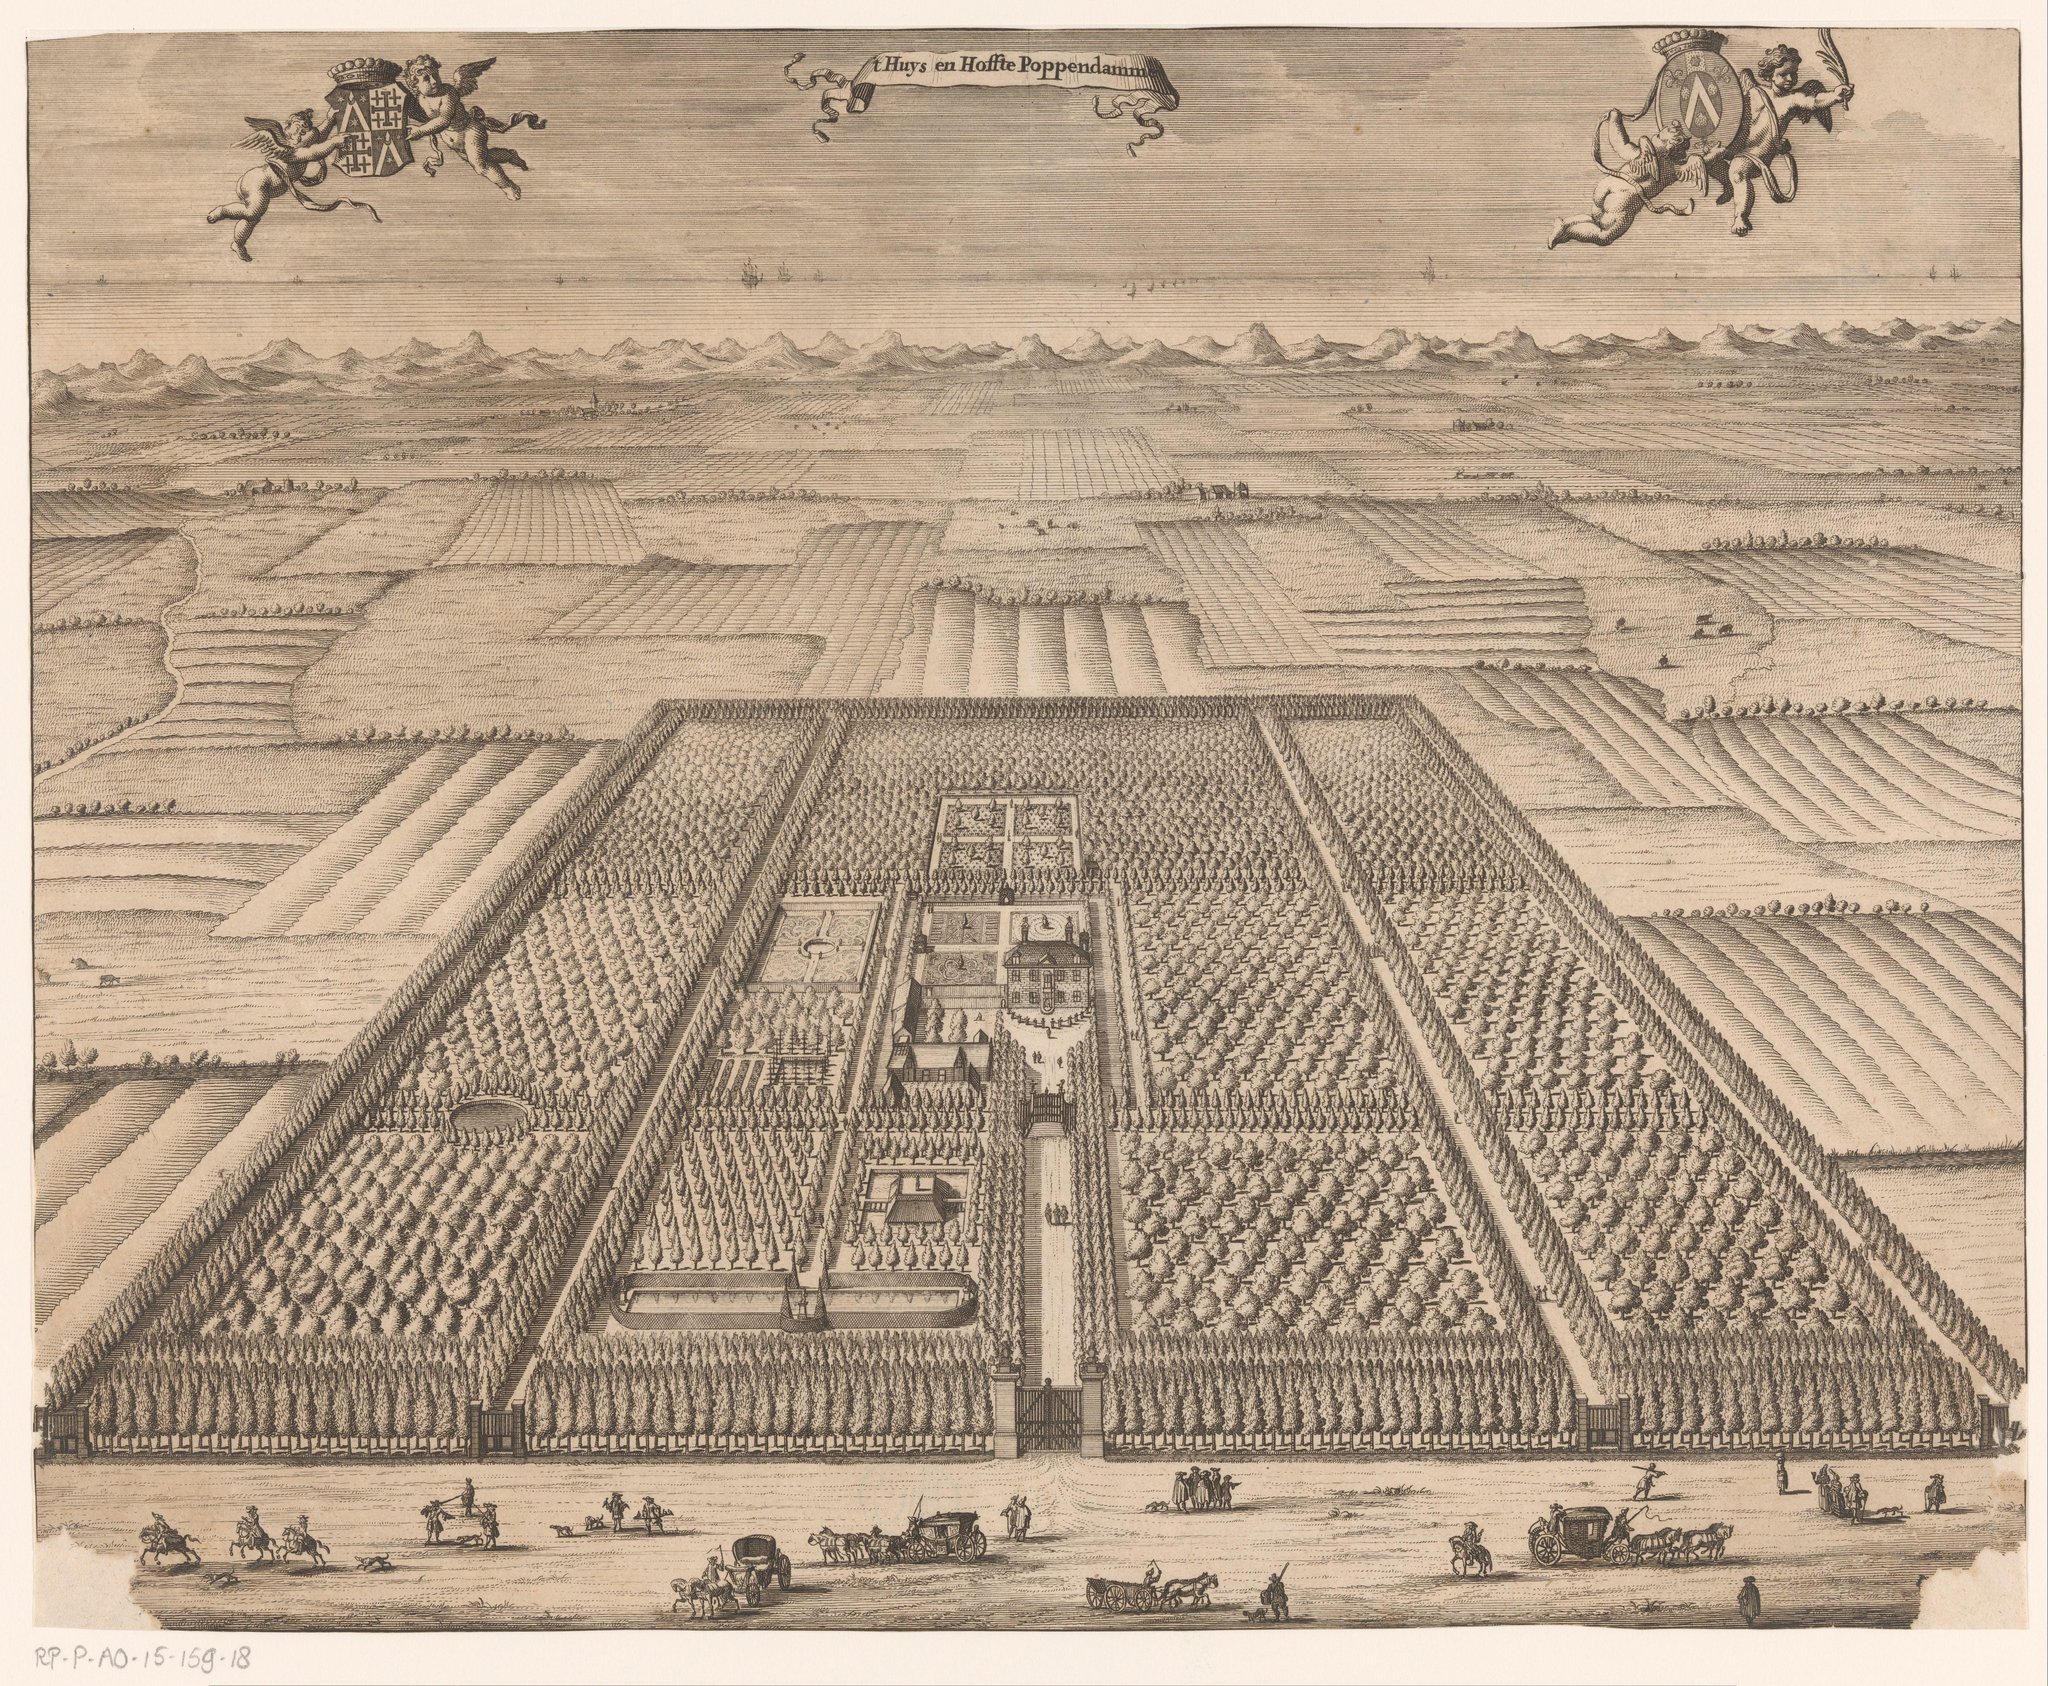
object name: print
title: Gezicht op de buitenplaats Hof te Poppendamme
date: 1696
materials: paper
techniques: engraving, etching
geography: middelburg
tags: dune coast, french or architectonic garden; formal garden, gate, entrance, orchard, armorial bearing, heraldry, country-house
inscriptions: collector's mark: Lugt 195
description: Gezicht op de buitenplaats Hof te Poppendamme op Walcheren, in vogelvluchtperspectief. In het midden het buitenhuis met daaromheen de tuinen en boomgaarden. Op de achtergrond de duinen en zee. Linksboven twee putti met het wapen van eigenaar Johan de Mauregnault, in het midden een banderol met de titel, rechtsboven twee putti met een ander wapen, mogelijk dat van zijn echtgenote.